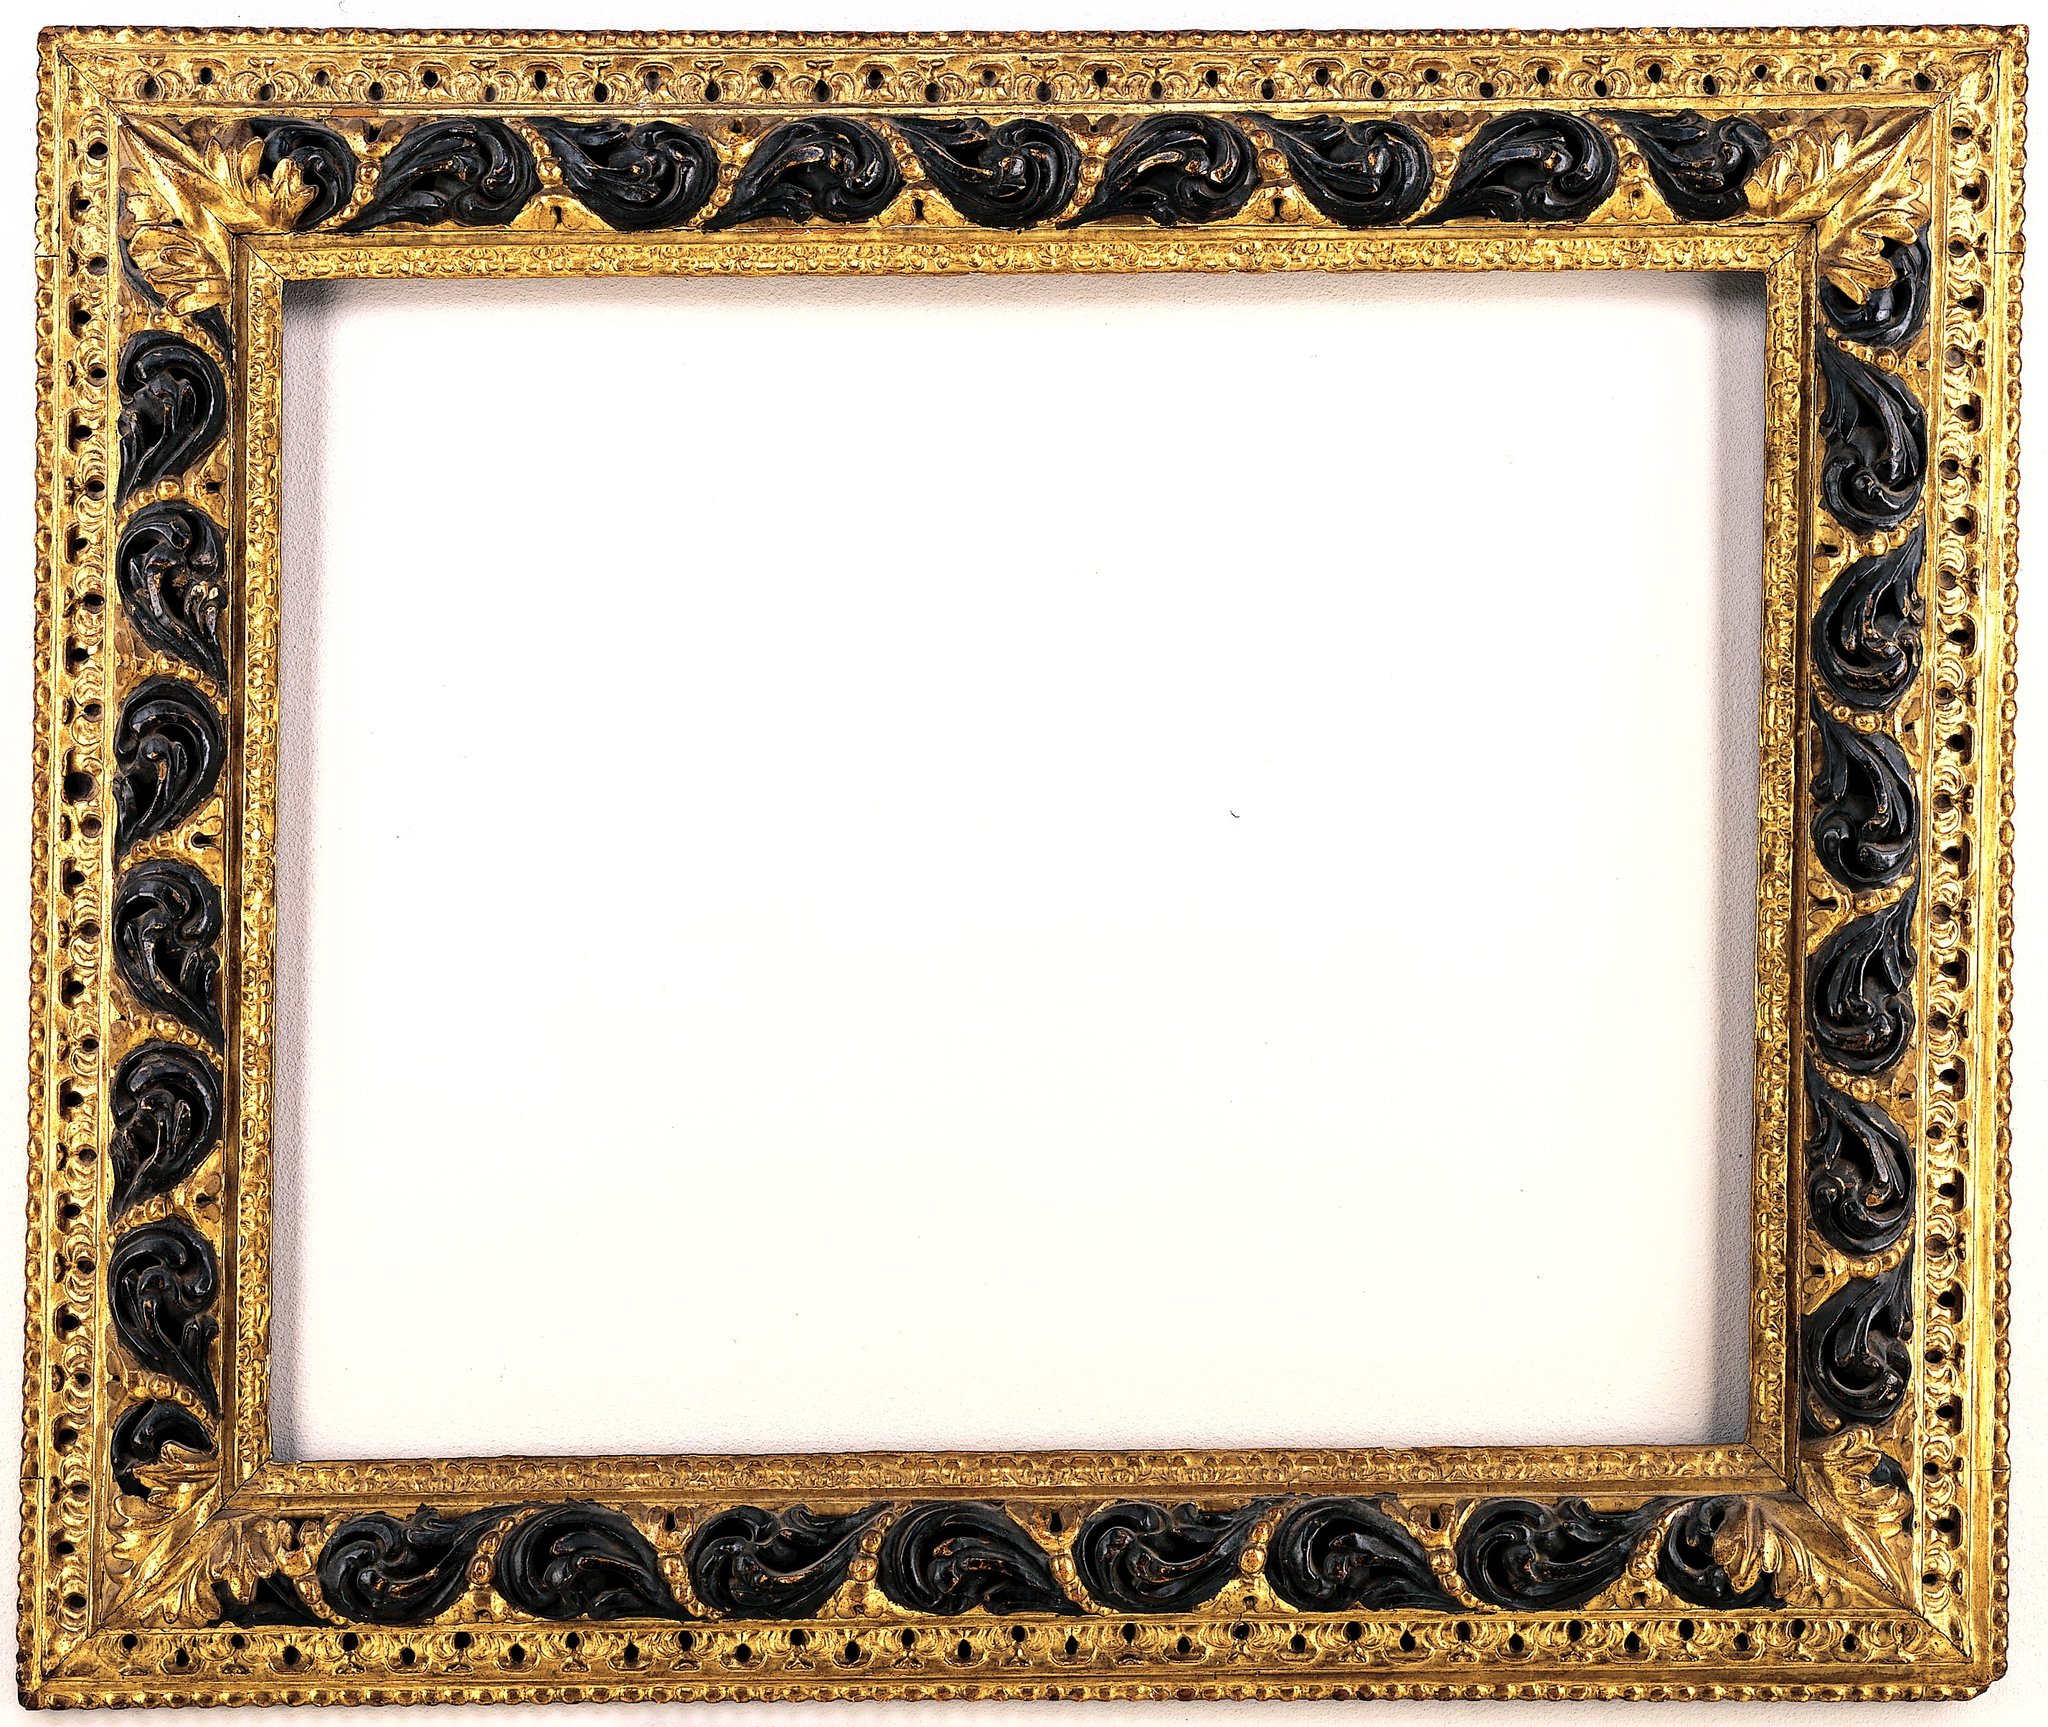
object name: frame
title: Wreath frame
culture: italian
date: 1567-1600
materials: wood